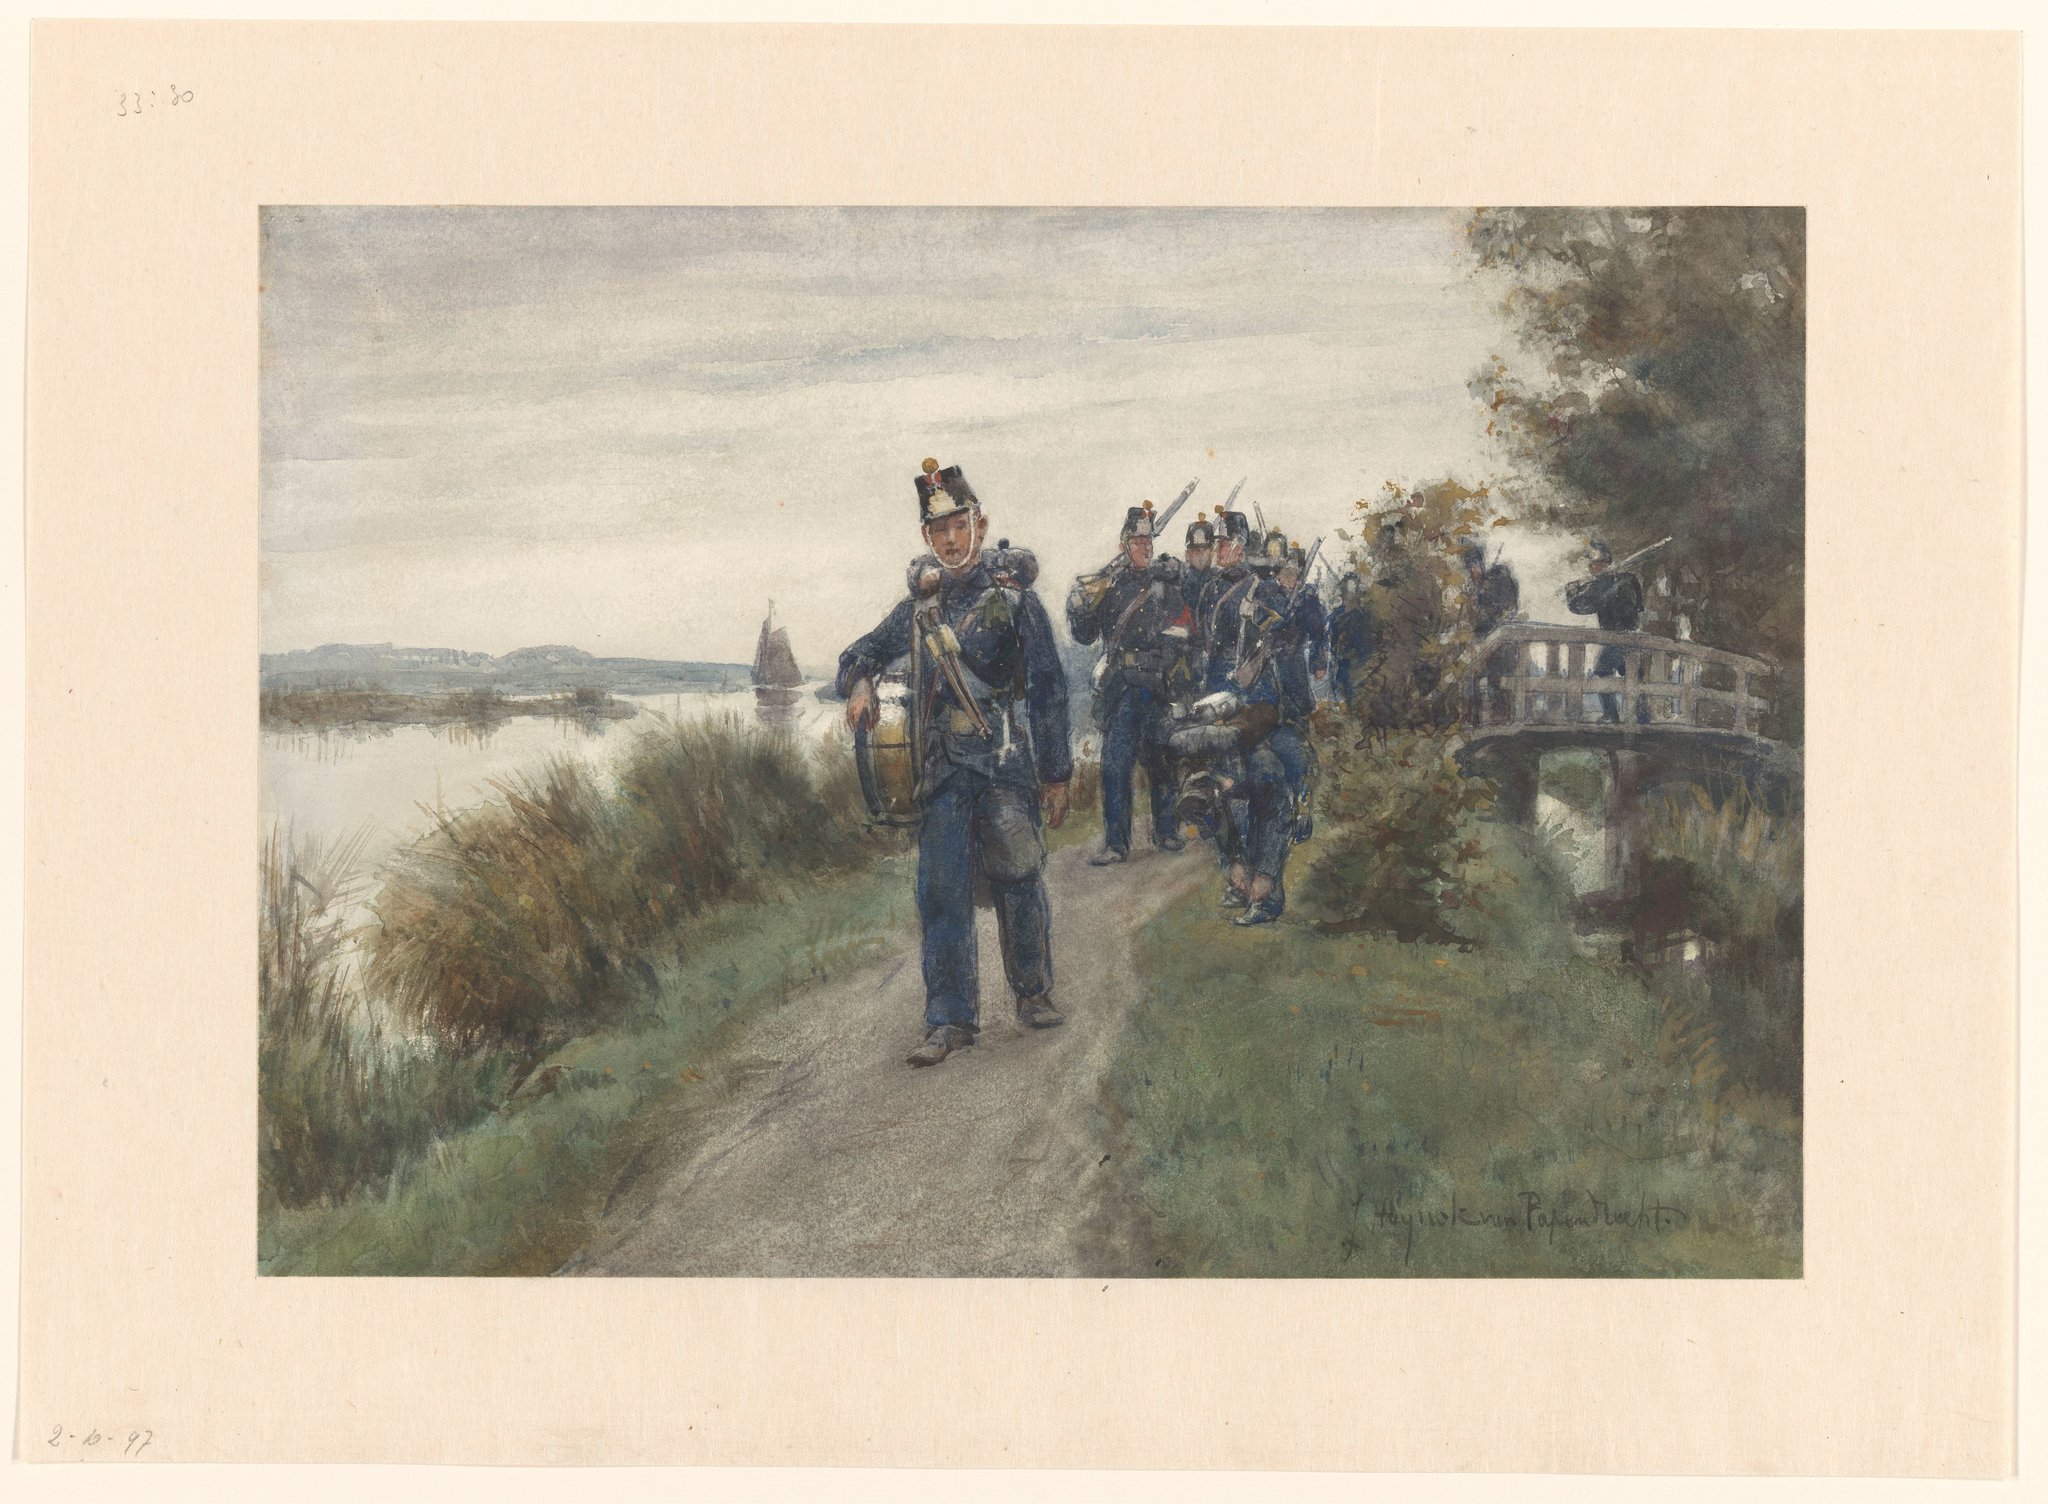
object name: drawing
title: Patrouille van de infanterie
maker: jan hoynck van papendrecht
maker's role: draughtsman, painter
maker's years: 1858-1933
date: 1868-1933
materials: paper, watercolor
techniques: brush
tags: military training, land forces (+ infantry)